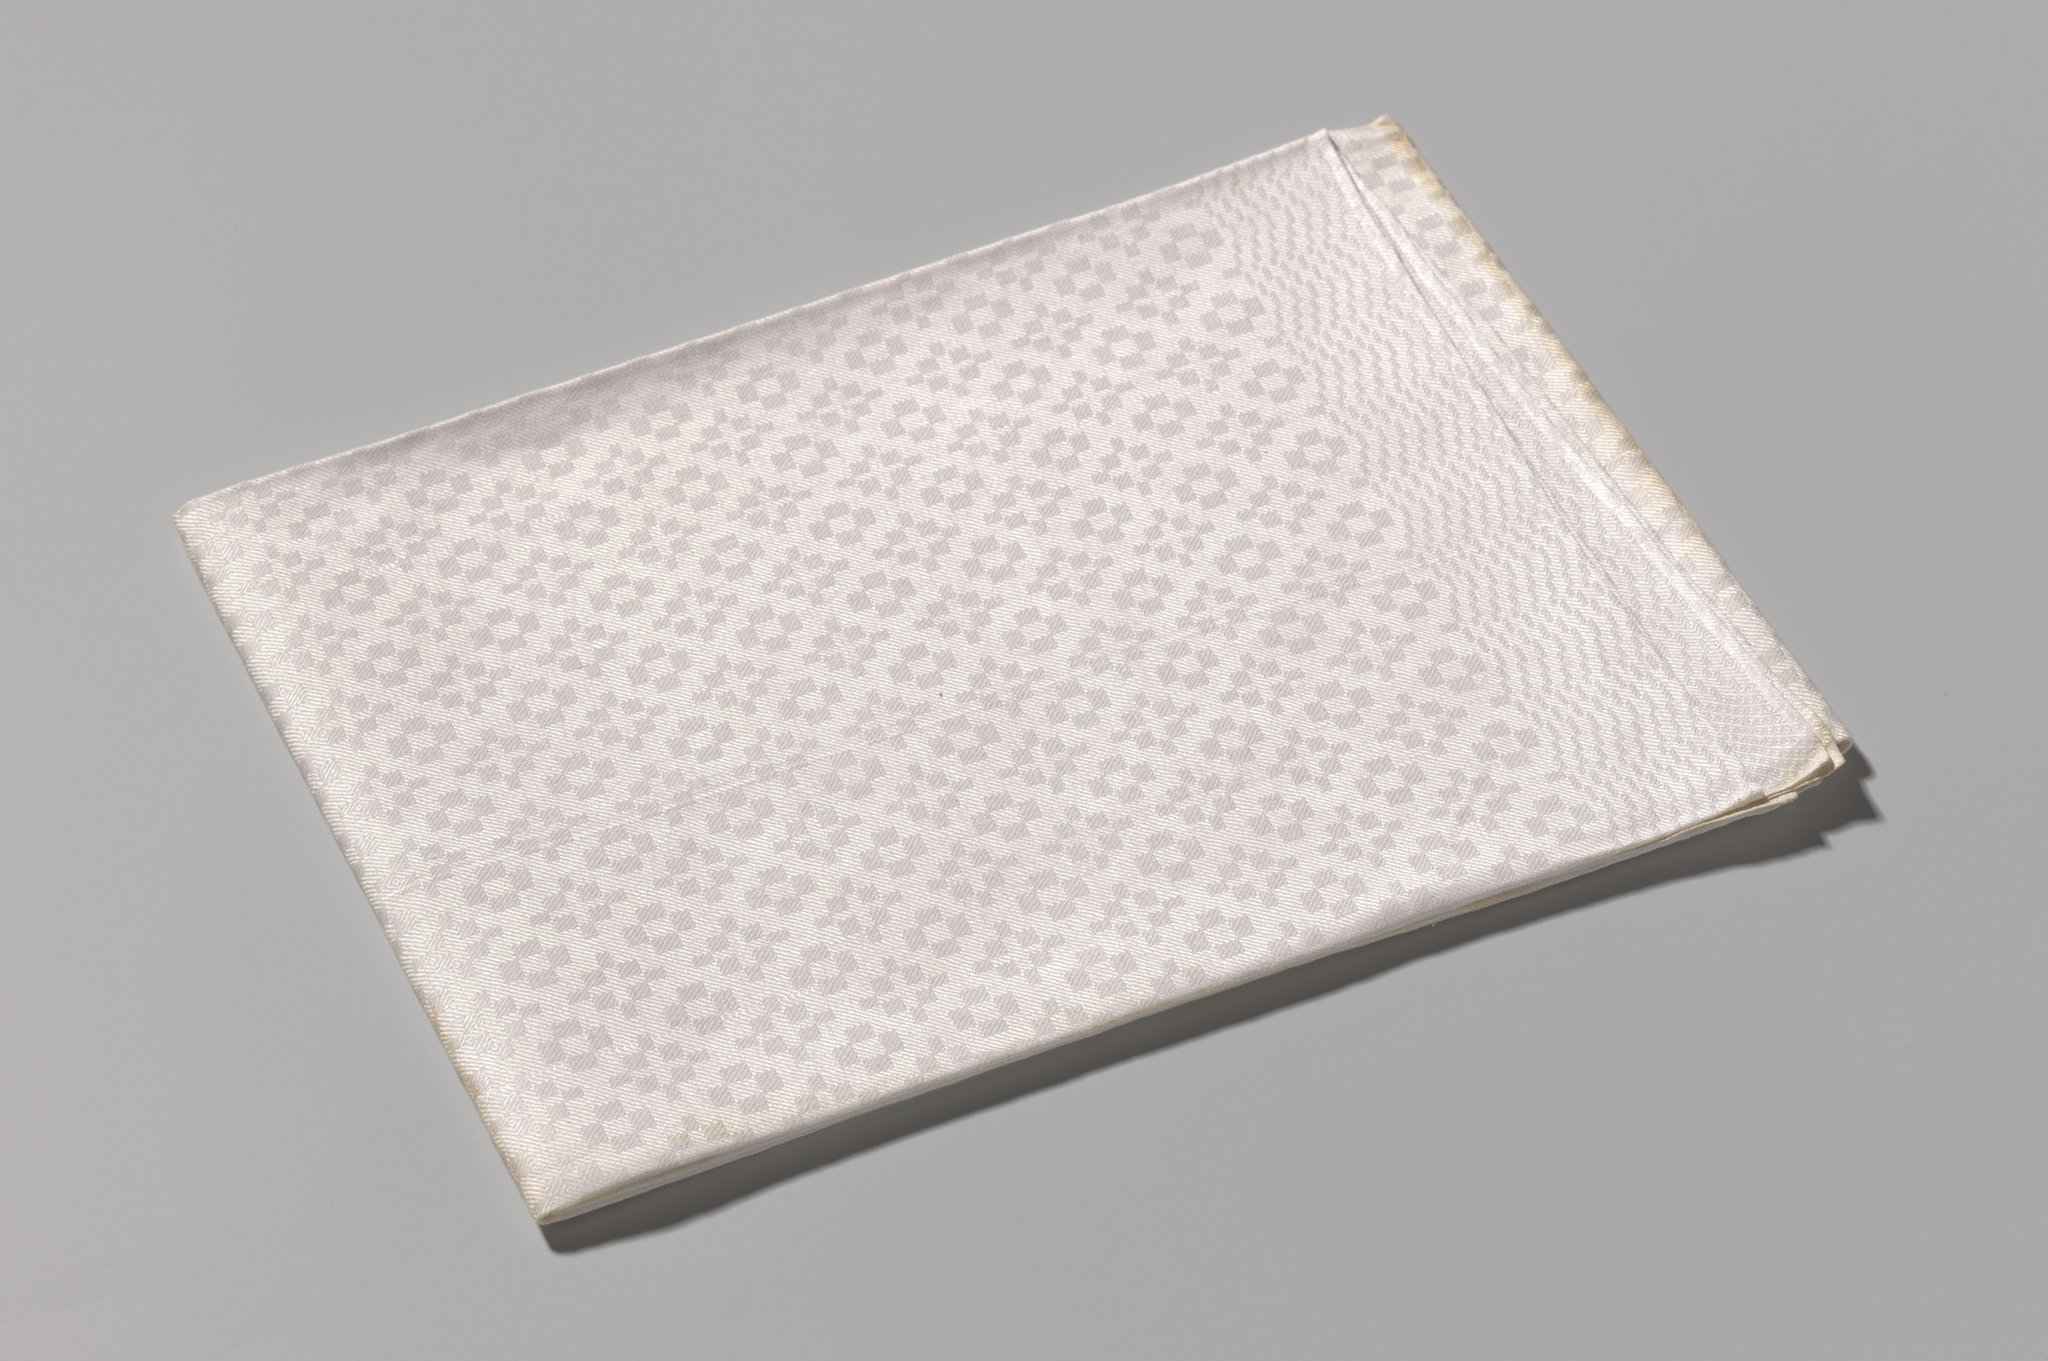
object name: napkin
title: Servet van linnen met pellenpatroon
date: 1700-1799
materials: linen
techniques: twill, peeled fabric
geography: northern netherlands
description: wit linnen servet met een pellen patroon in keper, merk kroon H 18 en X p poon